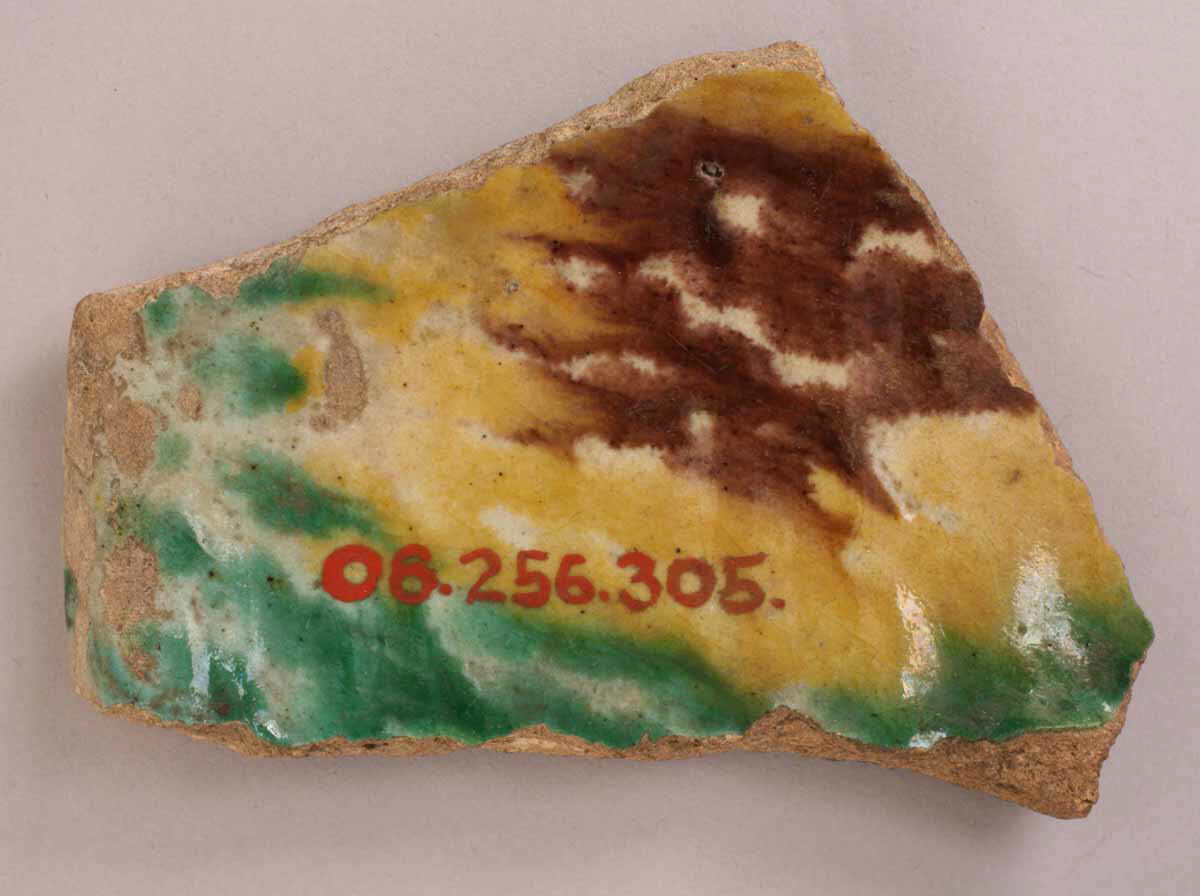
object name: fragment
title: Ceramic Fragment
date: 1001-1100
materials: earthenware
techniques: glazing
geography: egypt